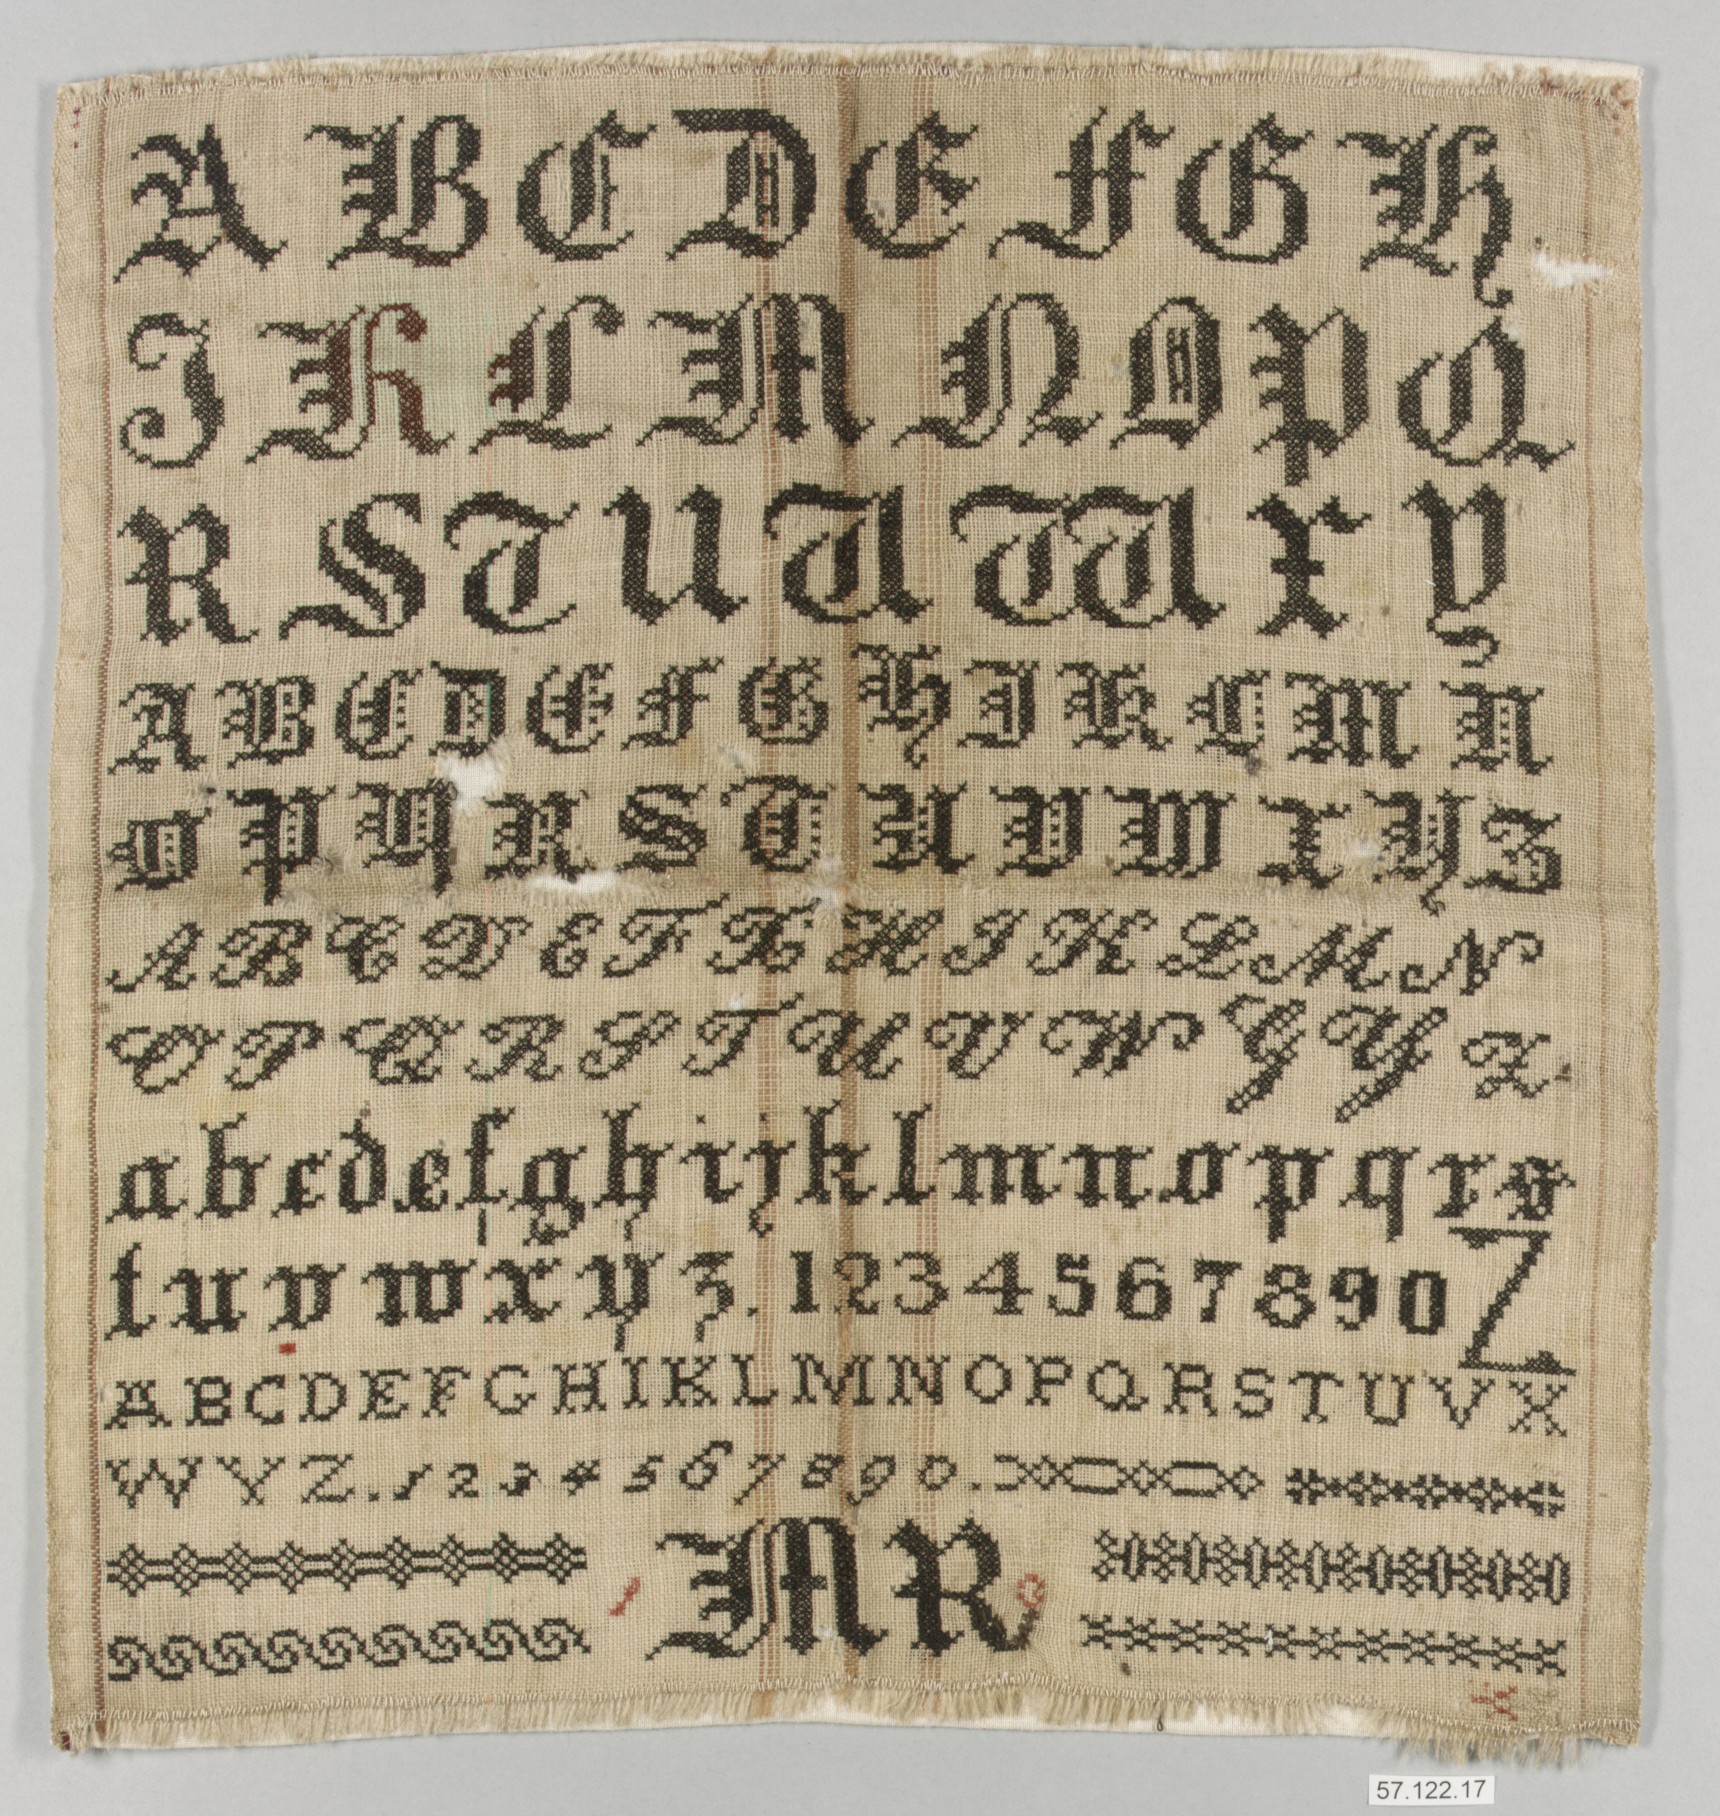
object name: sampler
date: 1801-1900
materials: canvas, silk, wool